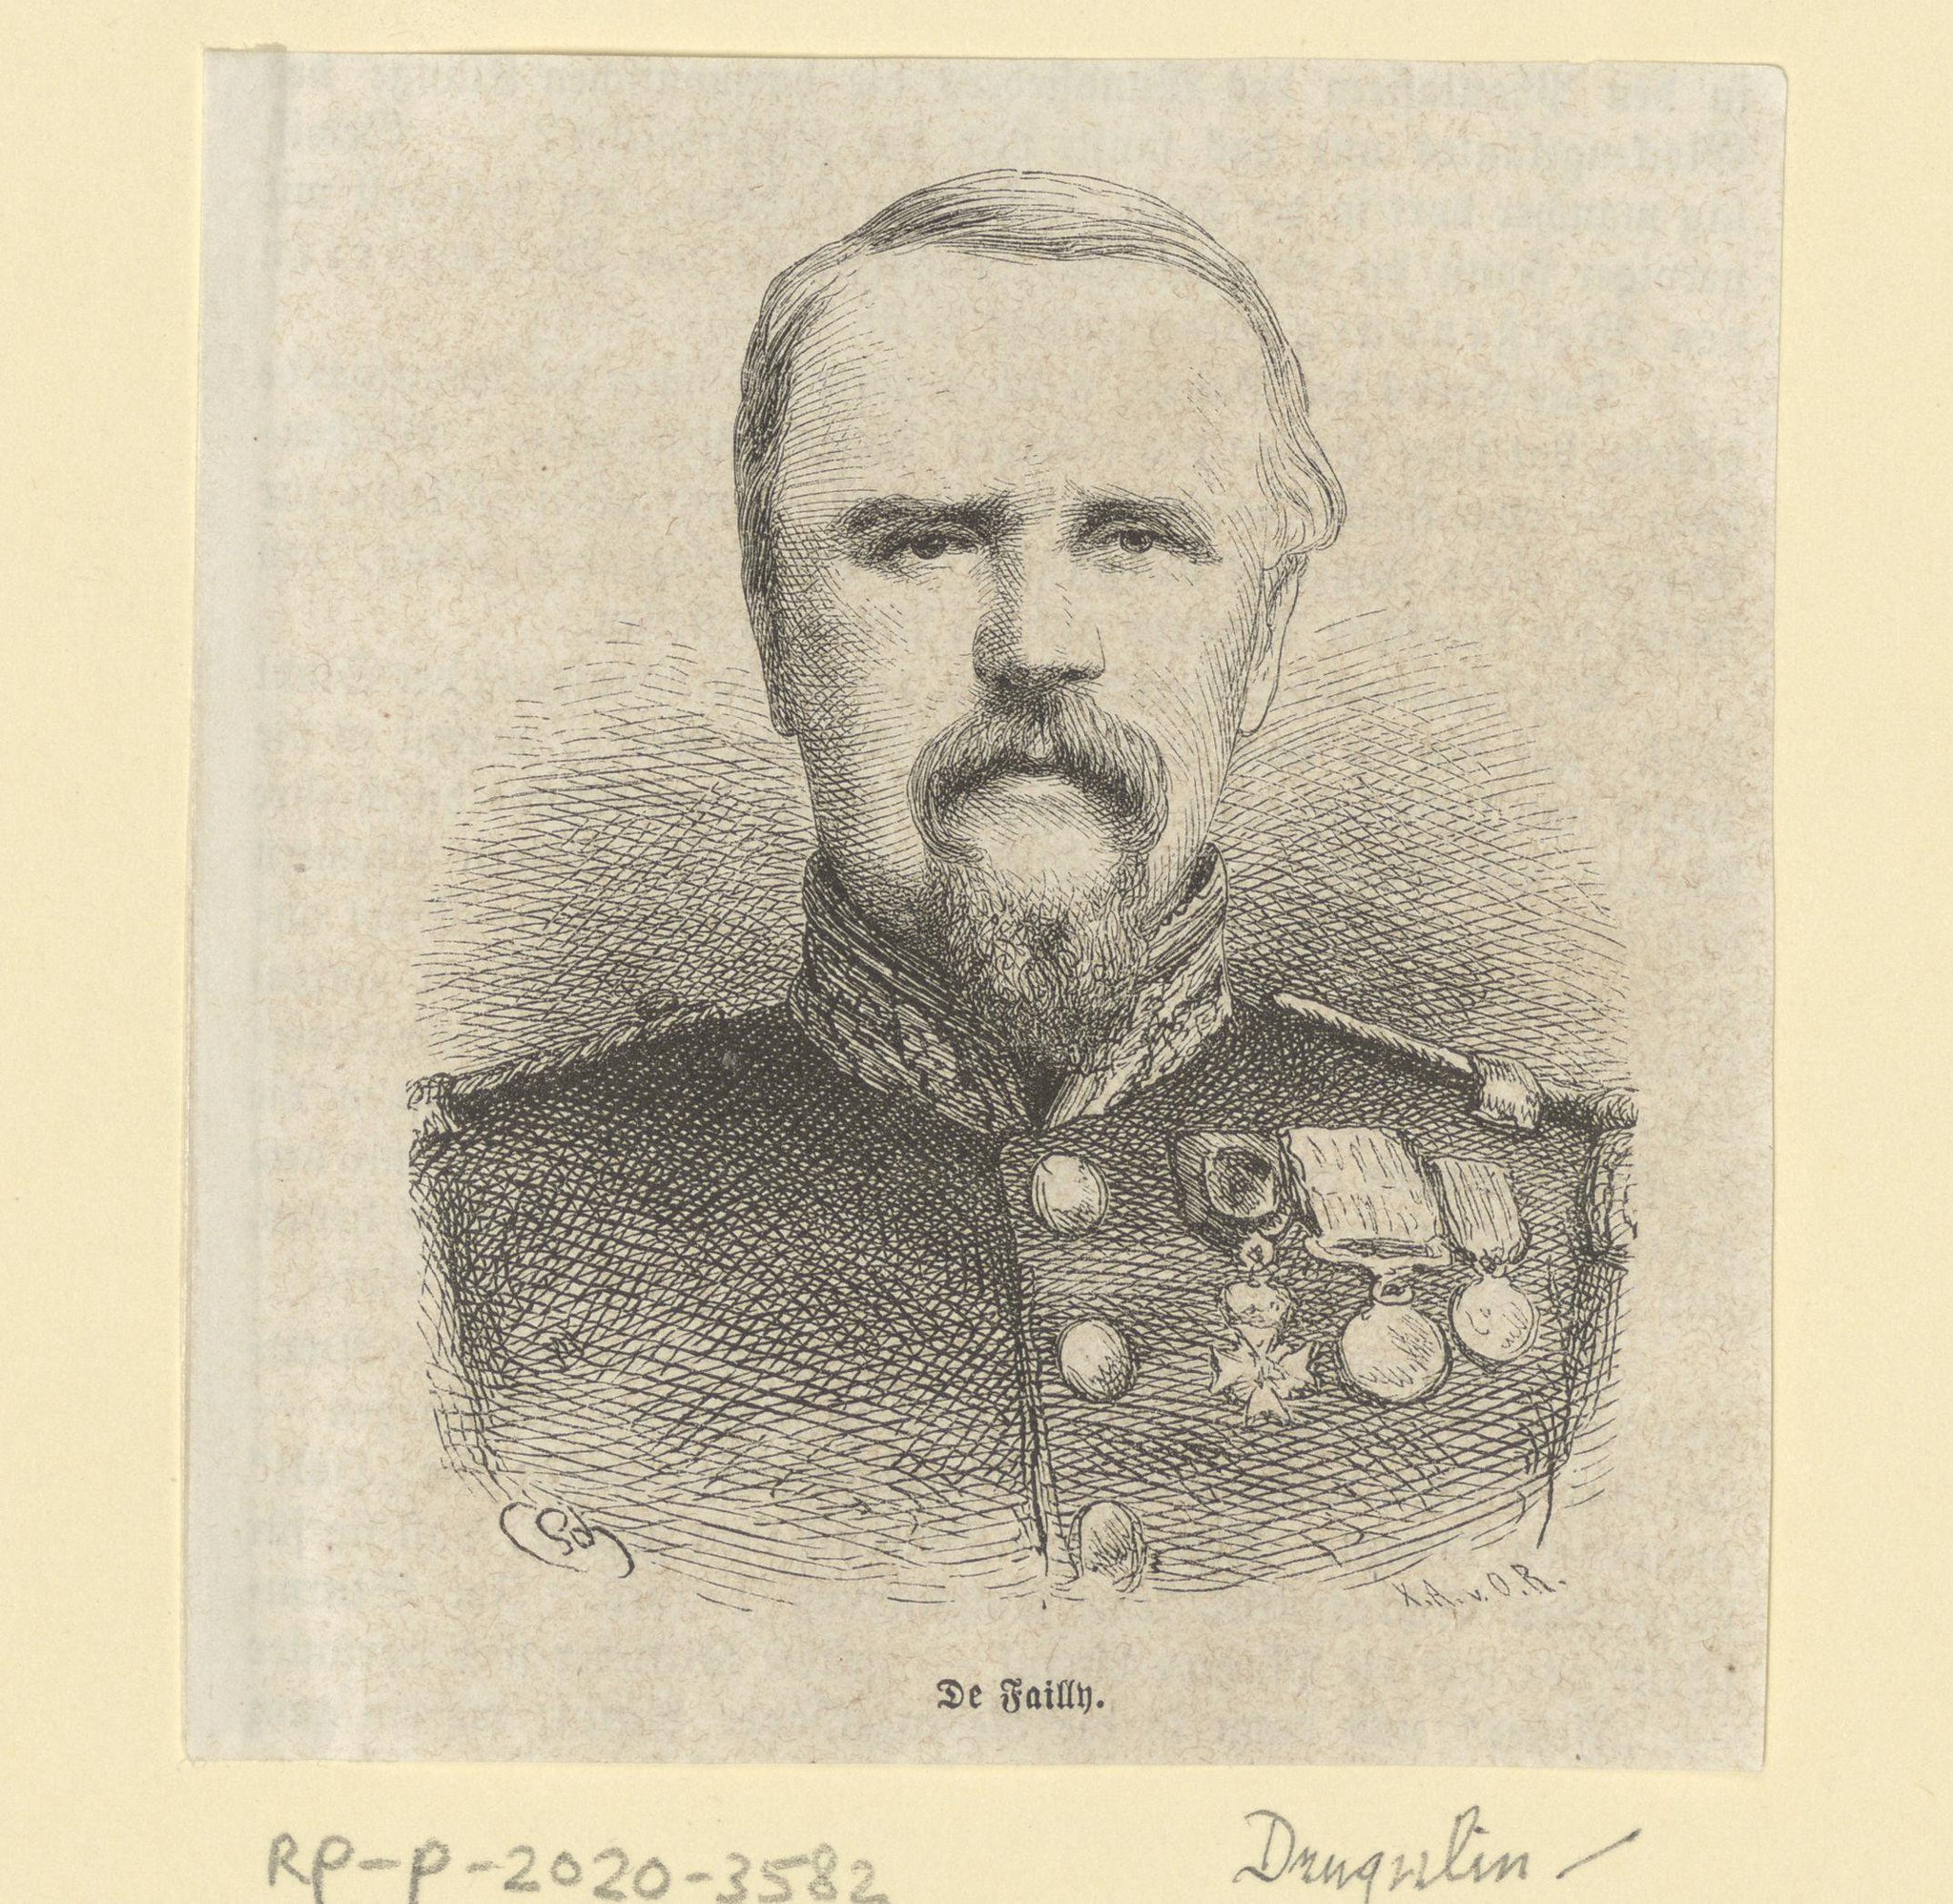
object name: print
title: Portret van Pierre Louis Charles de Failly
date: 1870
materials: paper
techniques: letterpress printing, engraving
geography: germany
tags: commander-in-chief, general, marshal, historical persons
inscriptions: monogram: ‘X.A.v.O.R.’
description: Prent uit: Daheim: ein Deutsches Familienblatt mit Illustrationen 6 (1870), nr. 51.